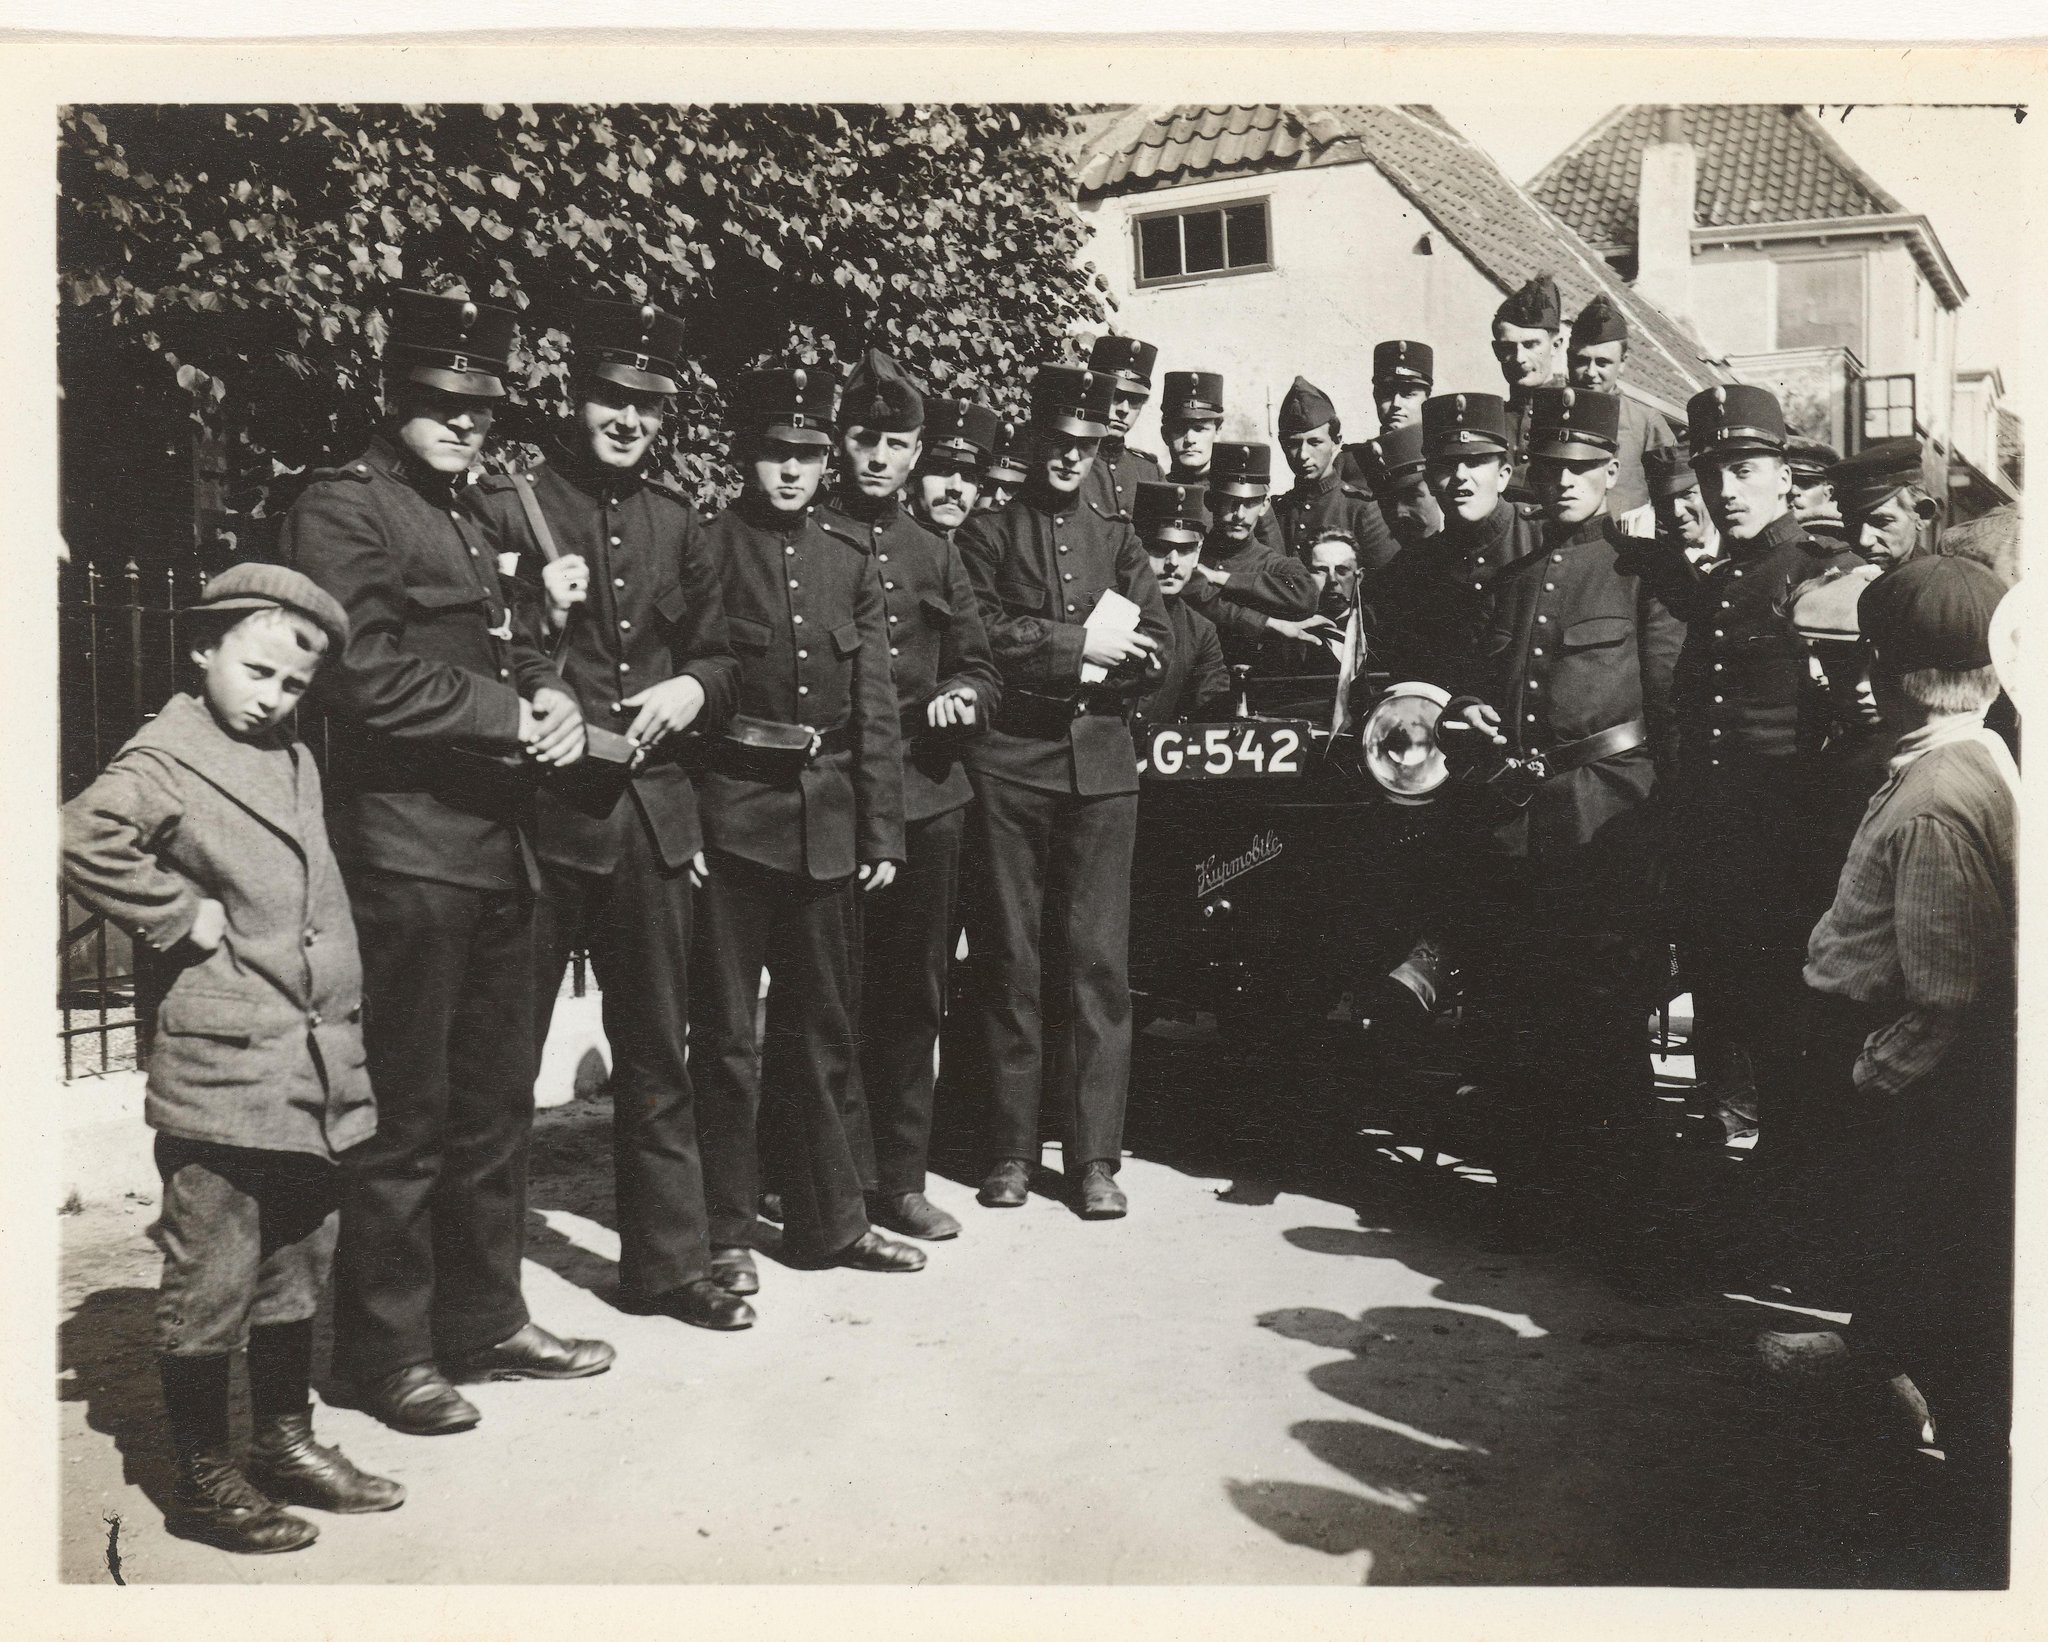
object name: photograph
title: Soldaten in en bij een Hupmobile in Alphen aan den Rijn, tijdens de algehele mobilisatie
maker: dirk van der mark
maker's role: amateurfotograaf, handelaar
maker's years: 1877-1934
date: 1914-1918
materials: paper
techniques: gelatin silver print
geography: alphen aan den rijn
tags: the soldier; the soldier's life, automobile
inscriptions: inscription: ‘Mobilisatie 1914/18/ Hupmobile Dirk van der Mark Jr’, number: ‘13’